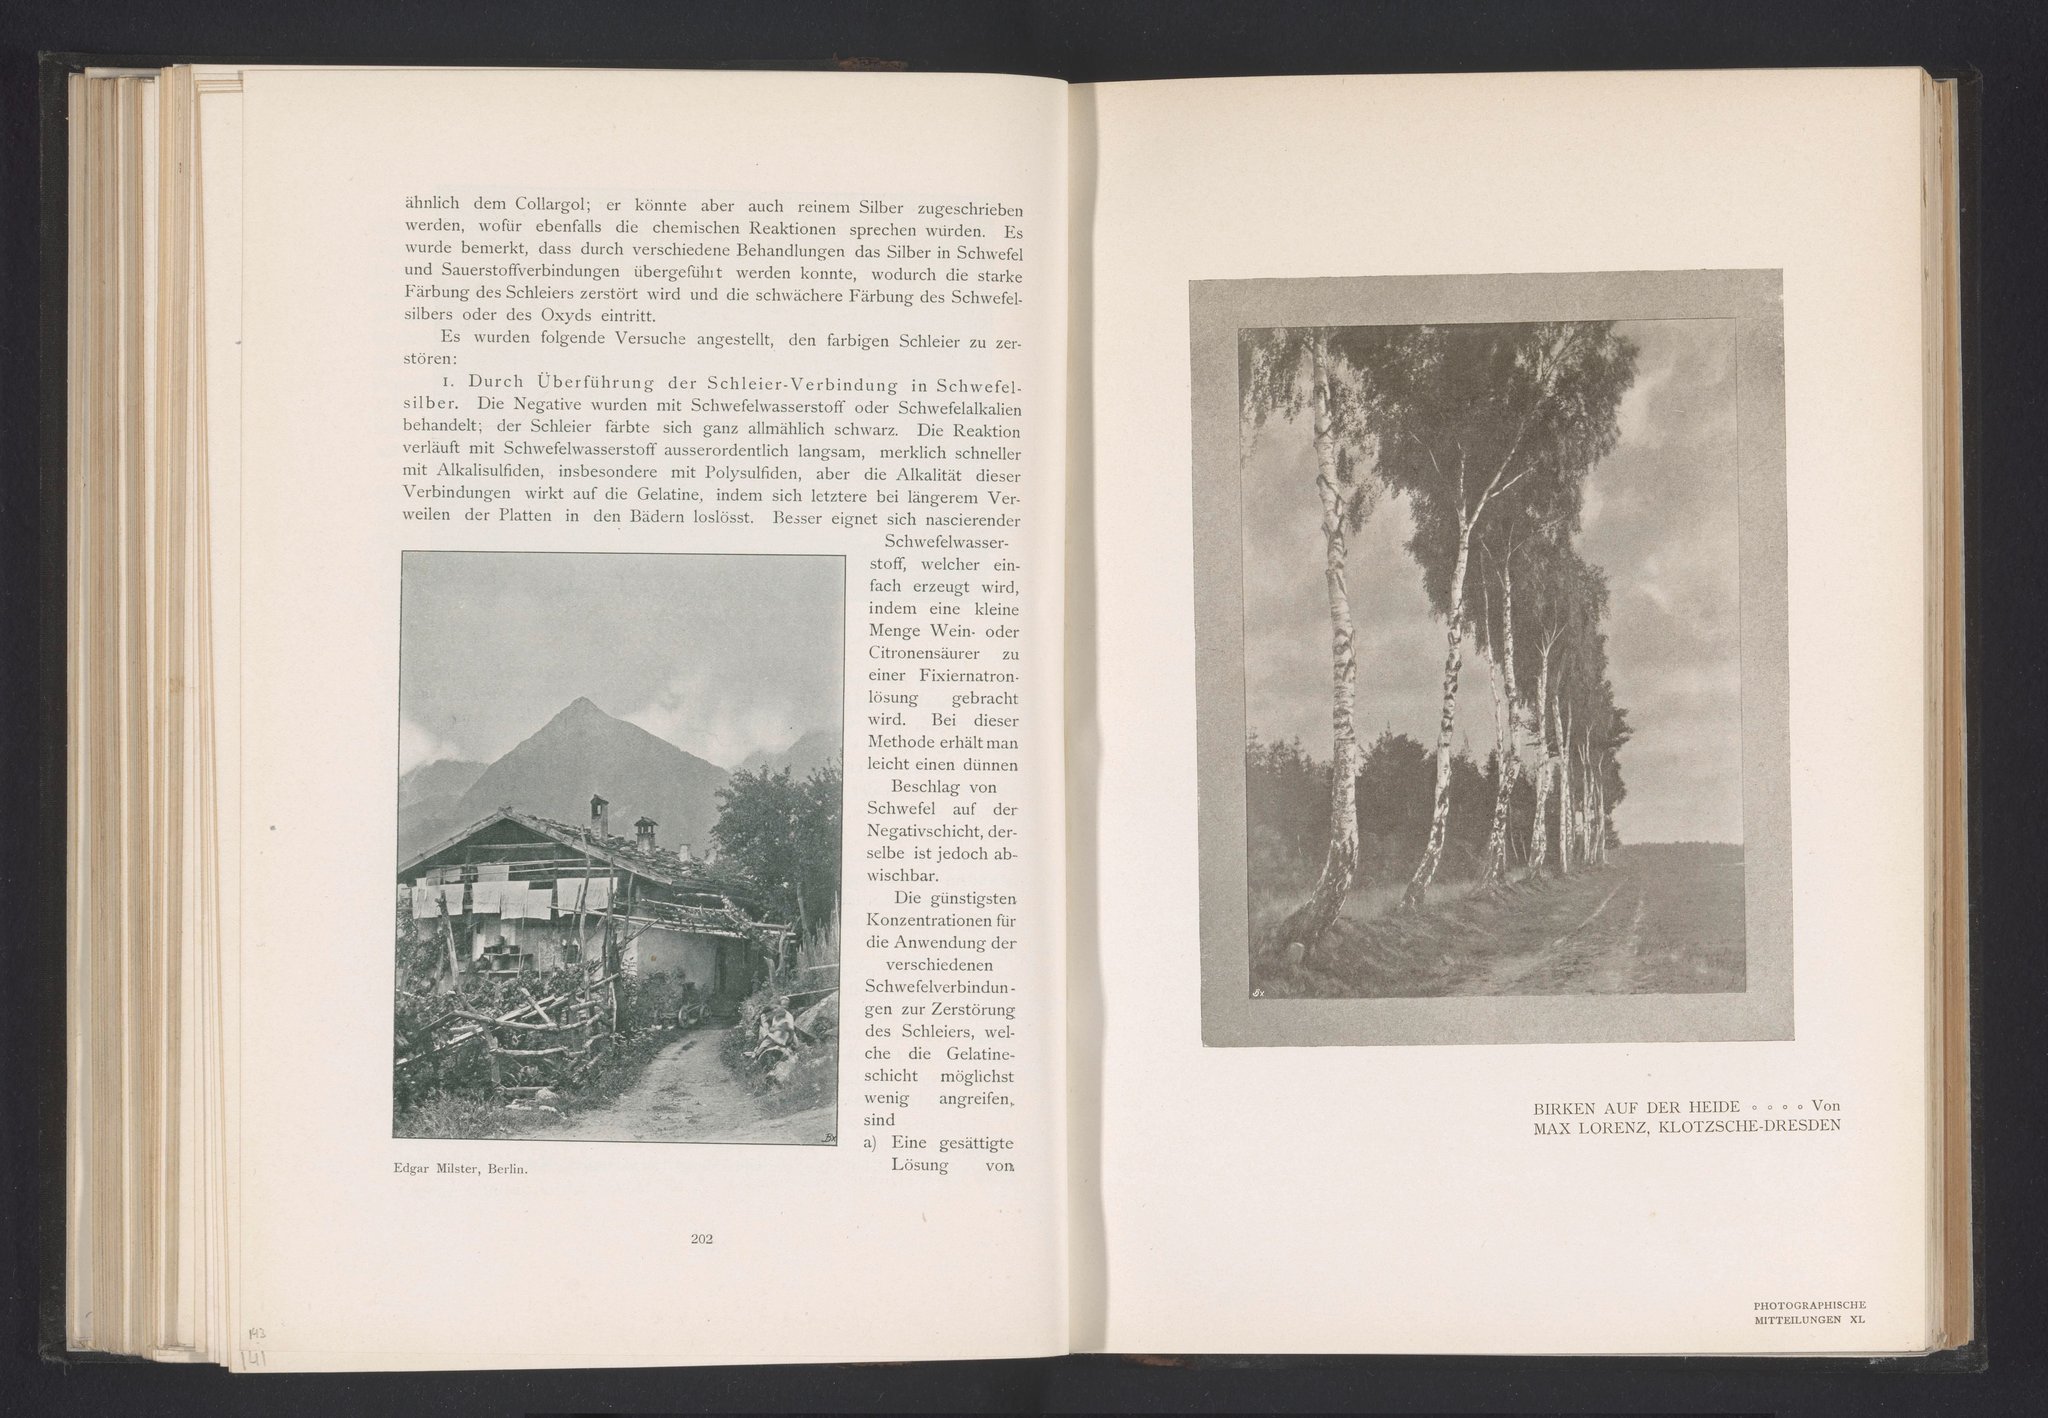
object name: page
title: Berkenbomen op de heide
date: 1898-1903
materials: paper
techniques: autotype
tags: landscapes, trees: birch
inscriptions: inscription: ‘Photographische Mitteilungen XL’, monogram: ‘BX’